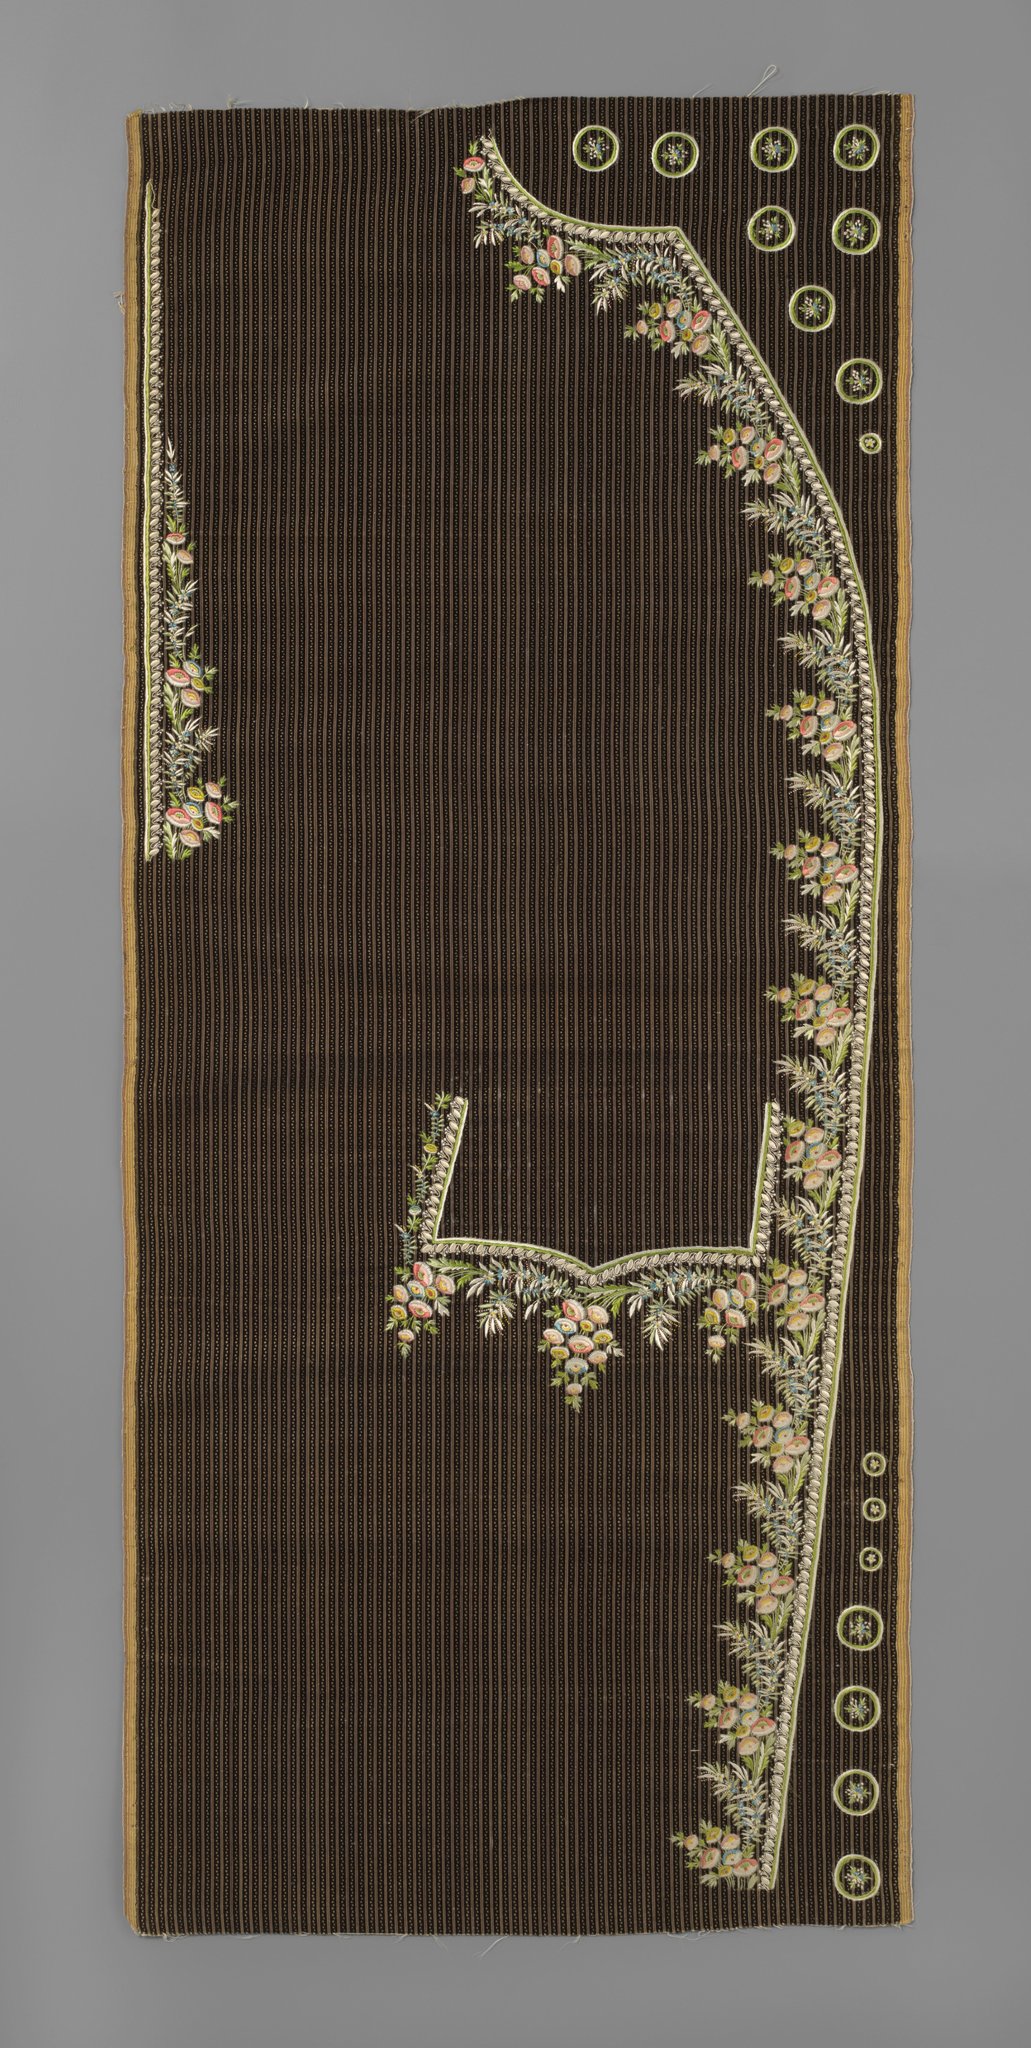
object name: coat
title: Paneel behorende bij een ongesneden frak van zijdenvelours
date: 1780-1790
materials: silk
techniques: embroidered, weave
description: In de 18e eeuw werden kledingstukken à disposition geborduurd. Dit betekent dat de contour van het kledingstuk met alle daarbij behorende versieringen door de borduurwerker werden geborduurd en pas daarna werden de panden of panneaux naar de kleermaker gebracht voor verdere verwerkingen. De knopen b.v. werden door de kleermaker uitgeknipt en rondom een kern van hout of ander stevig materiaal gewerkt.